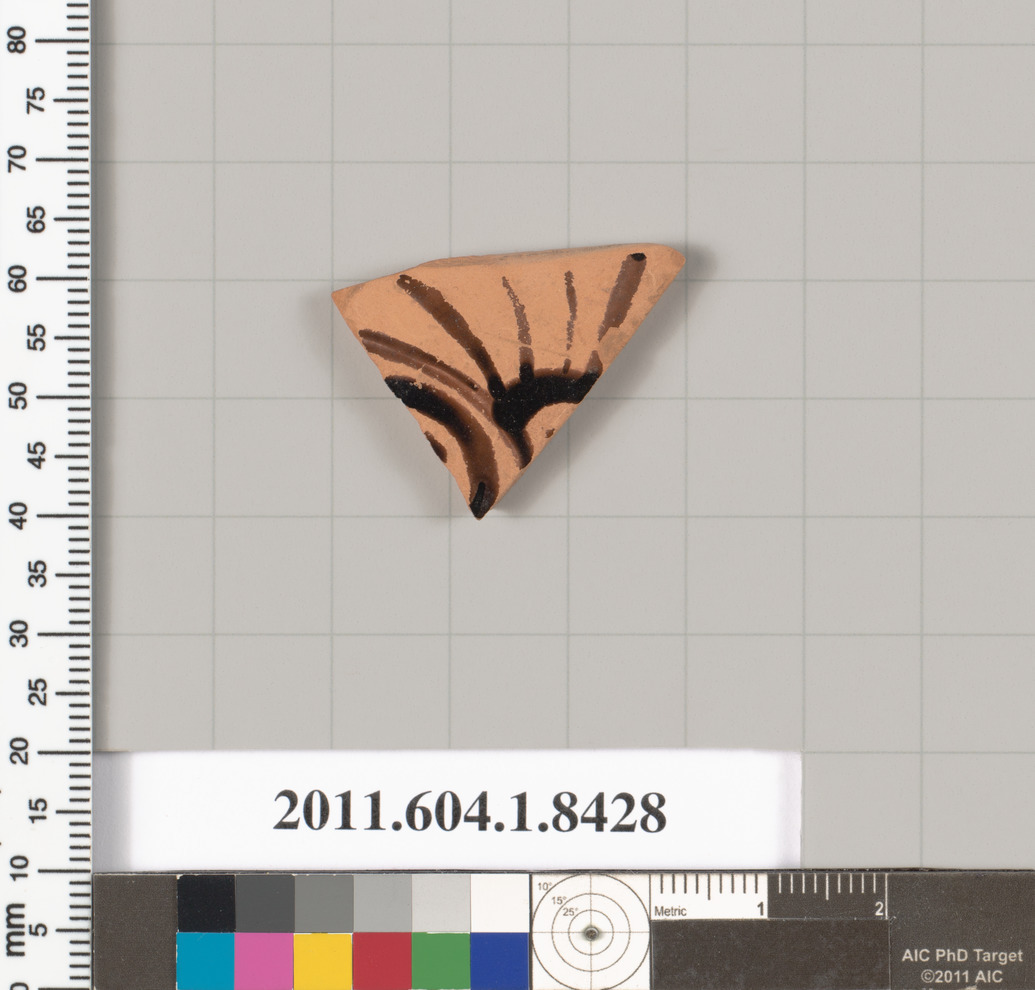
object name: kylix fragment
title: Terracotta fragment of a kylix (drinking cup)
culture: greek, attic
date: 434-368 BCE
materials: terracotta